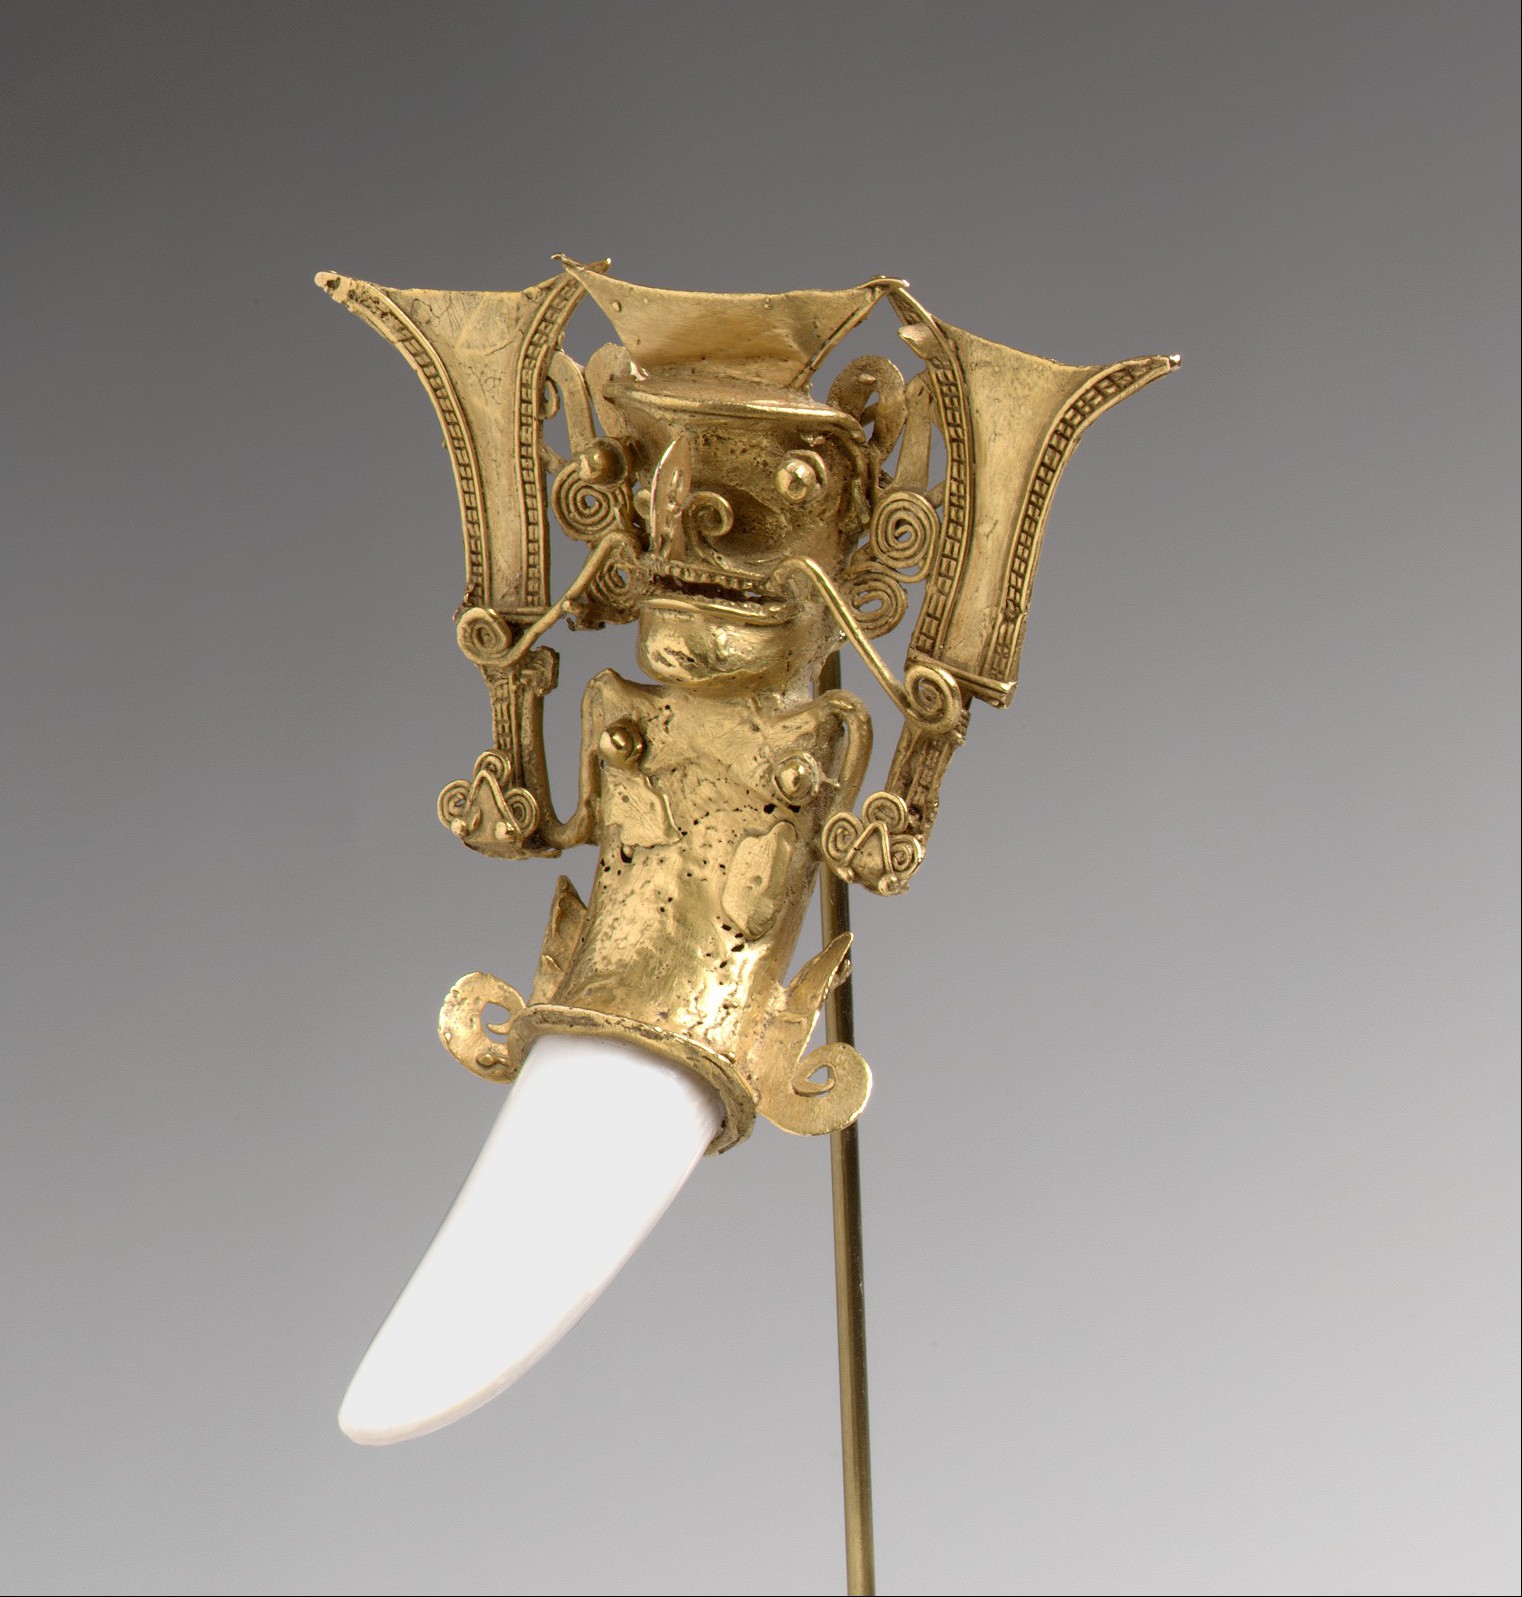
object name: pendant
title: Bat-Nosed Figure Pendant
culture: coclé, parita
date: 1101-1400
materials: gold, pigment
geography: panama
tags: human figures